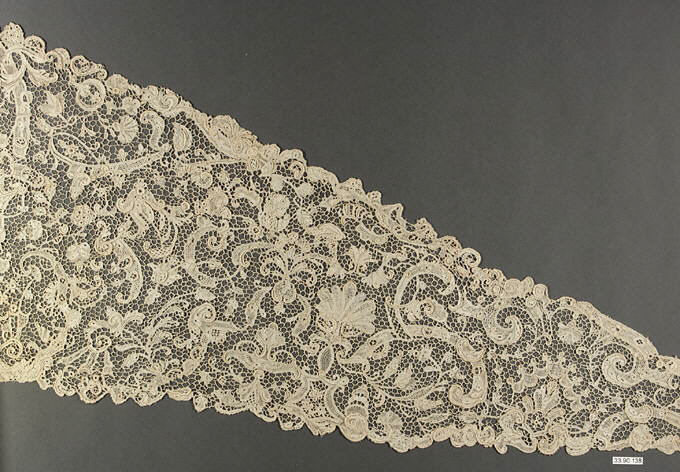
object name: cape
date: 1701-1733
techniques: lace